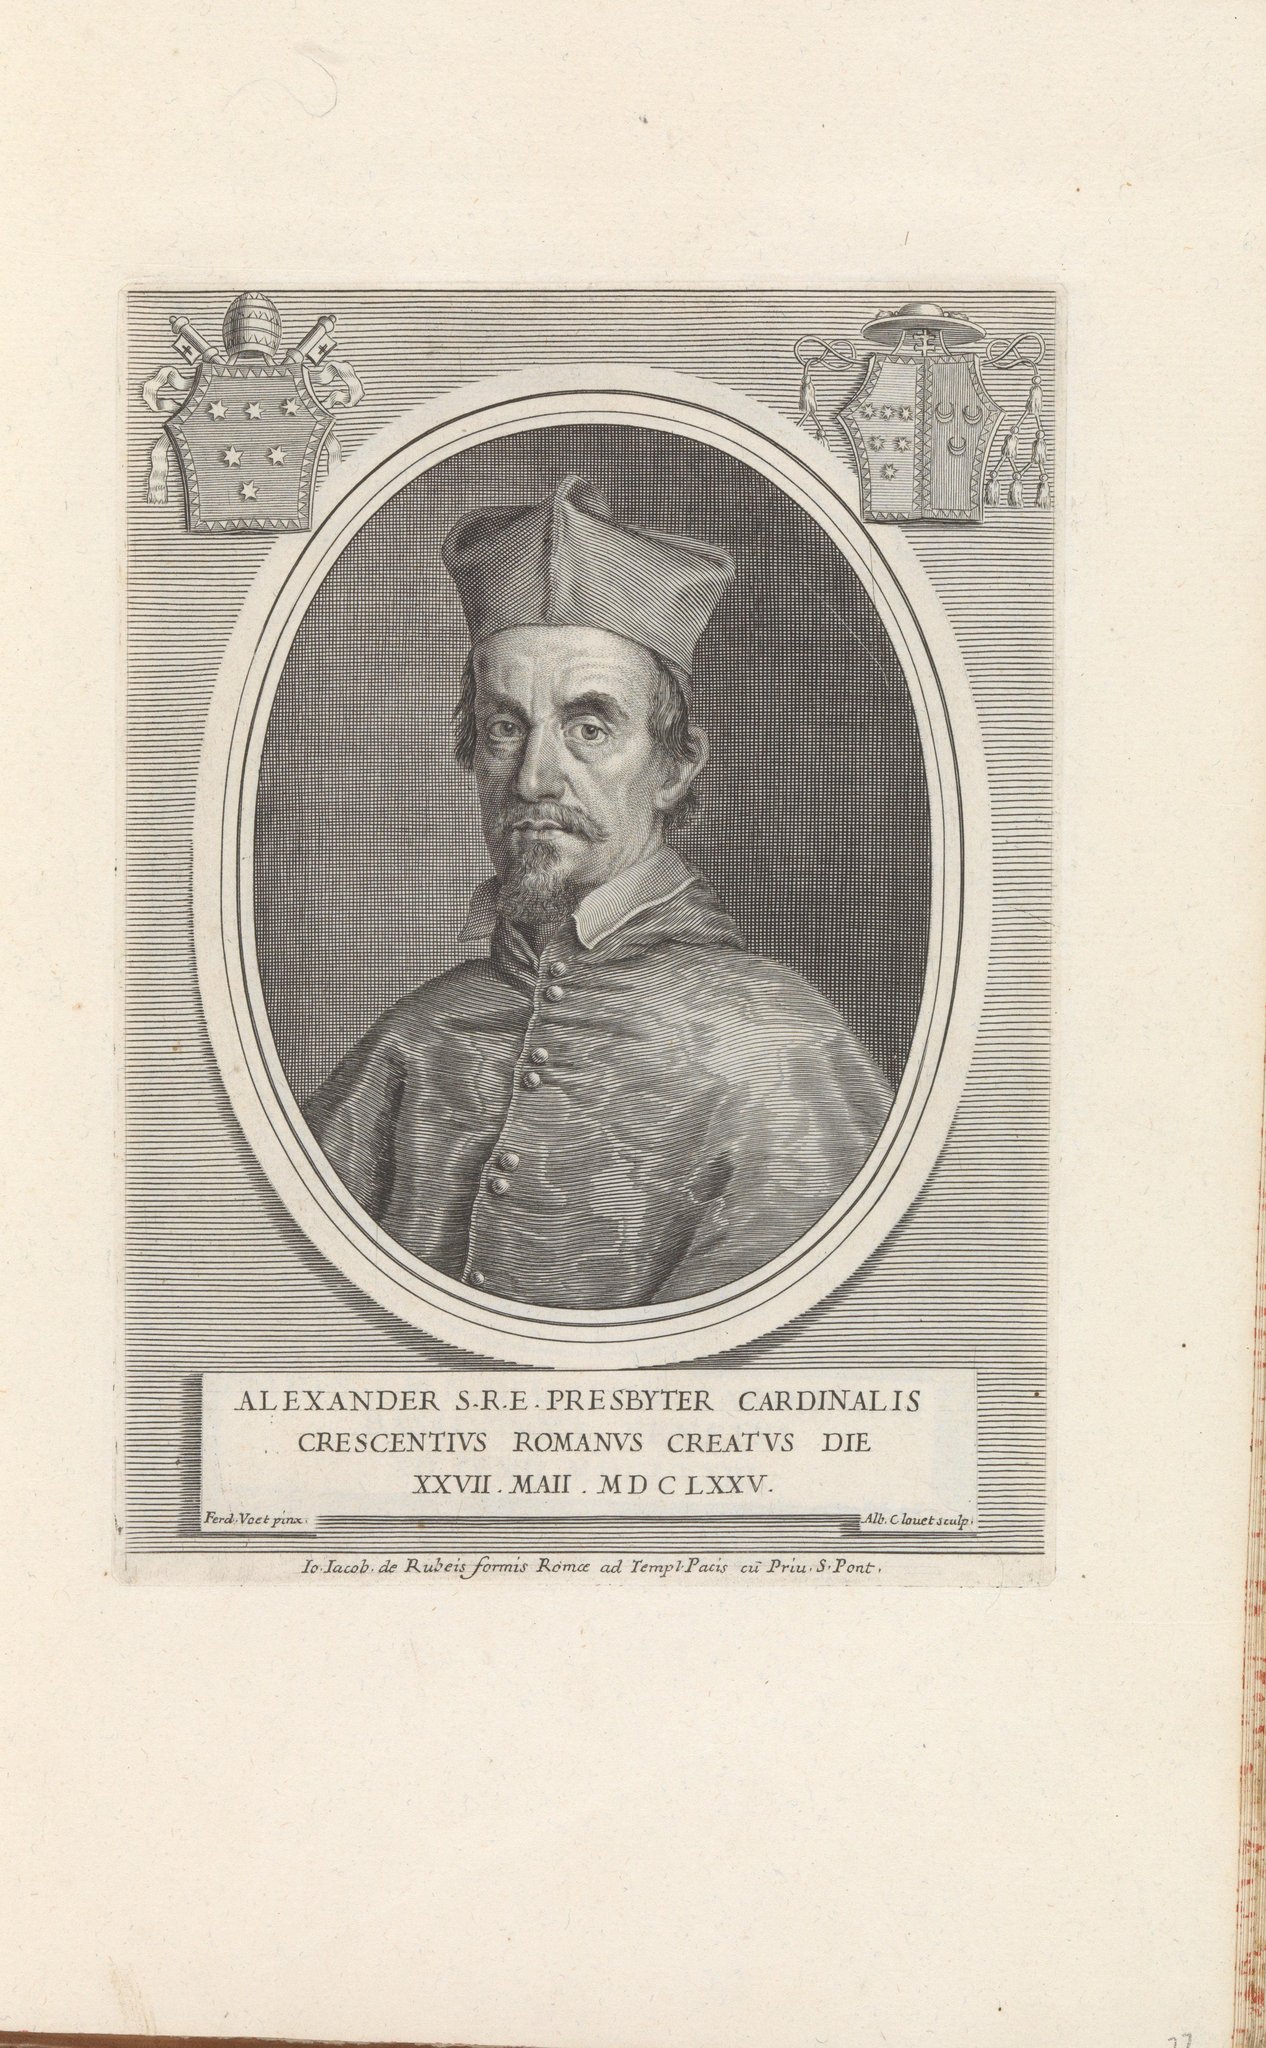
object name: album leaf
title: Effigies Nomina et Cognomina S.D.N. Alexandri Papae VII et RR. DD. SRE. Cardd (...).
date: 1675-1679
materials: paper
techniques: engraving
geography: rome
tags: rome, cardinal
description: Portret van kardinaal Alessandro Crescenzi. Linksboven het wapen van paus Clemens X en rechtsboven het wapen van de kardinaal. Onderaan een onderschrift in het Latijn. De prent maakt deel uit van een album.